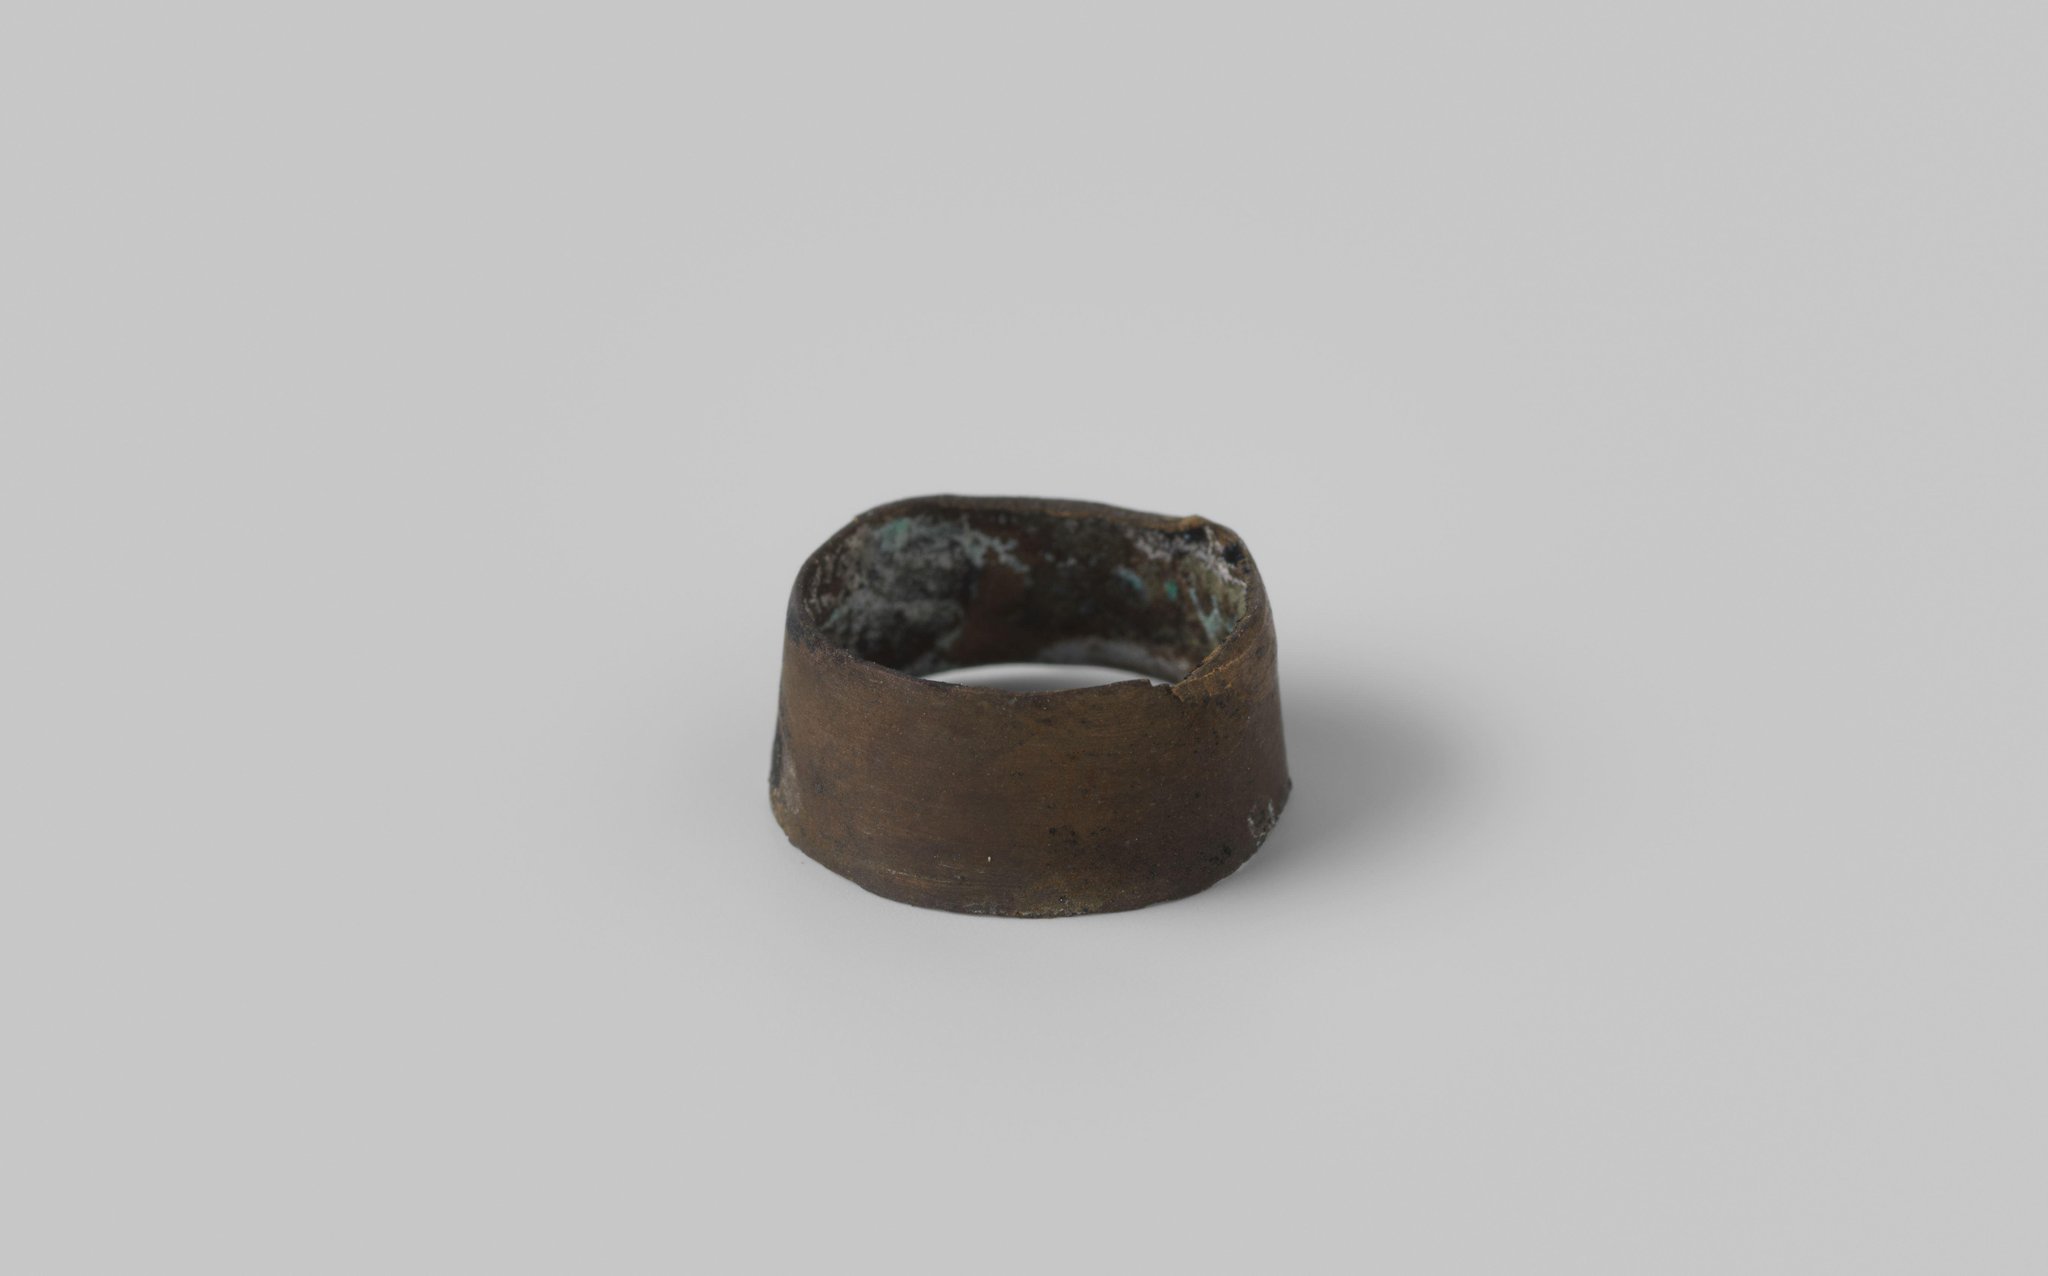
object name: knife handle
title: Messenheftring uit het wrak van de Oost-Indiëvaarder Hollandia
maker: Anonymous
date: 1700-1743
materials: copper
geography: netherlands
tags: verenigde oostindische compagnie, hollandia (schip), annet